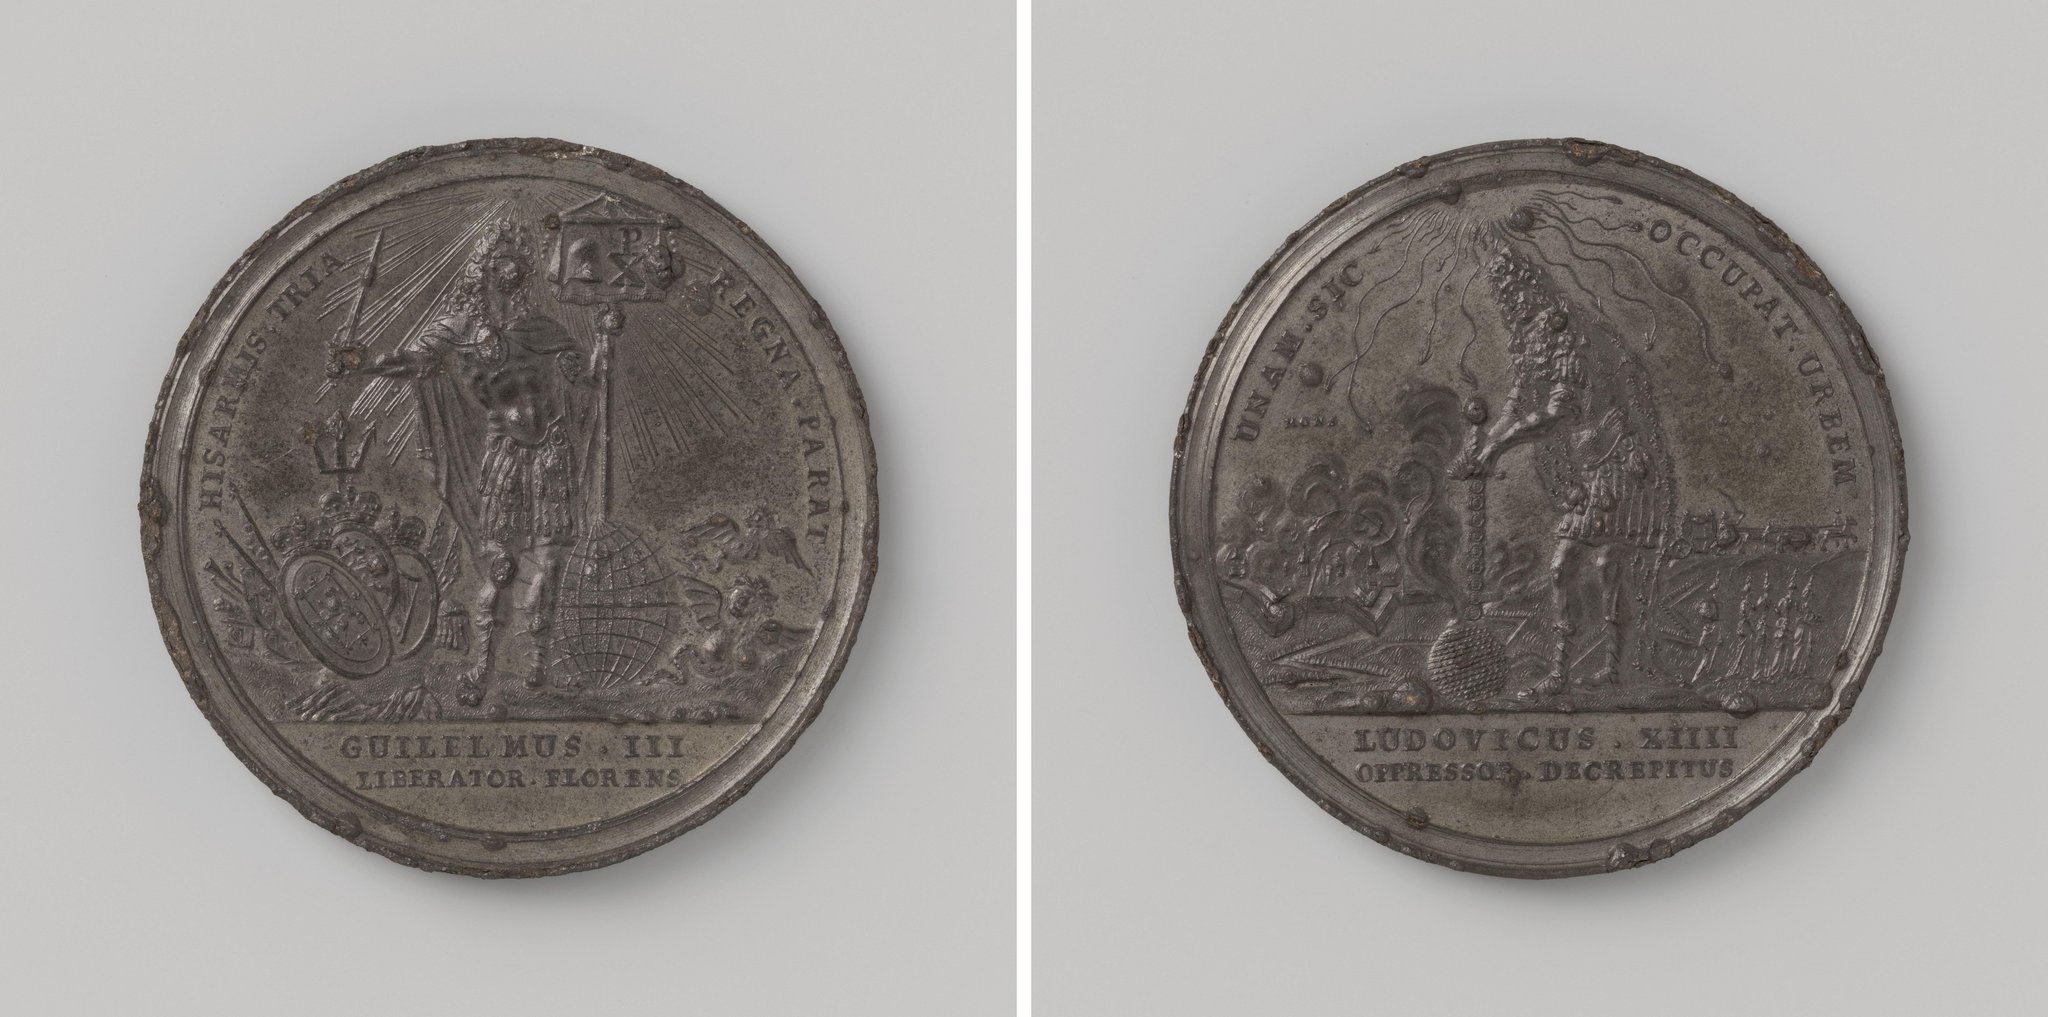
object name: copy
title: Willem III, bevrijder van Groot-Britannie en Lodewijk XIV, de bedrieger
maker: Anonymous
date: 1691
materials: tin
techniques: striking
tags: the hague, william iii (prince of orange and king of england, scotland, and ireland), lodewijk xiv (koning van frankrijk)